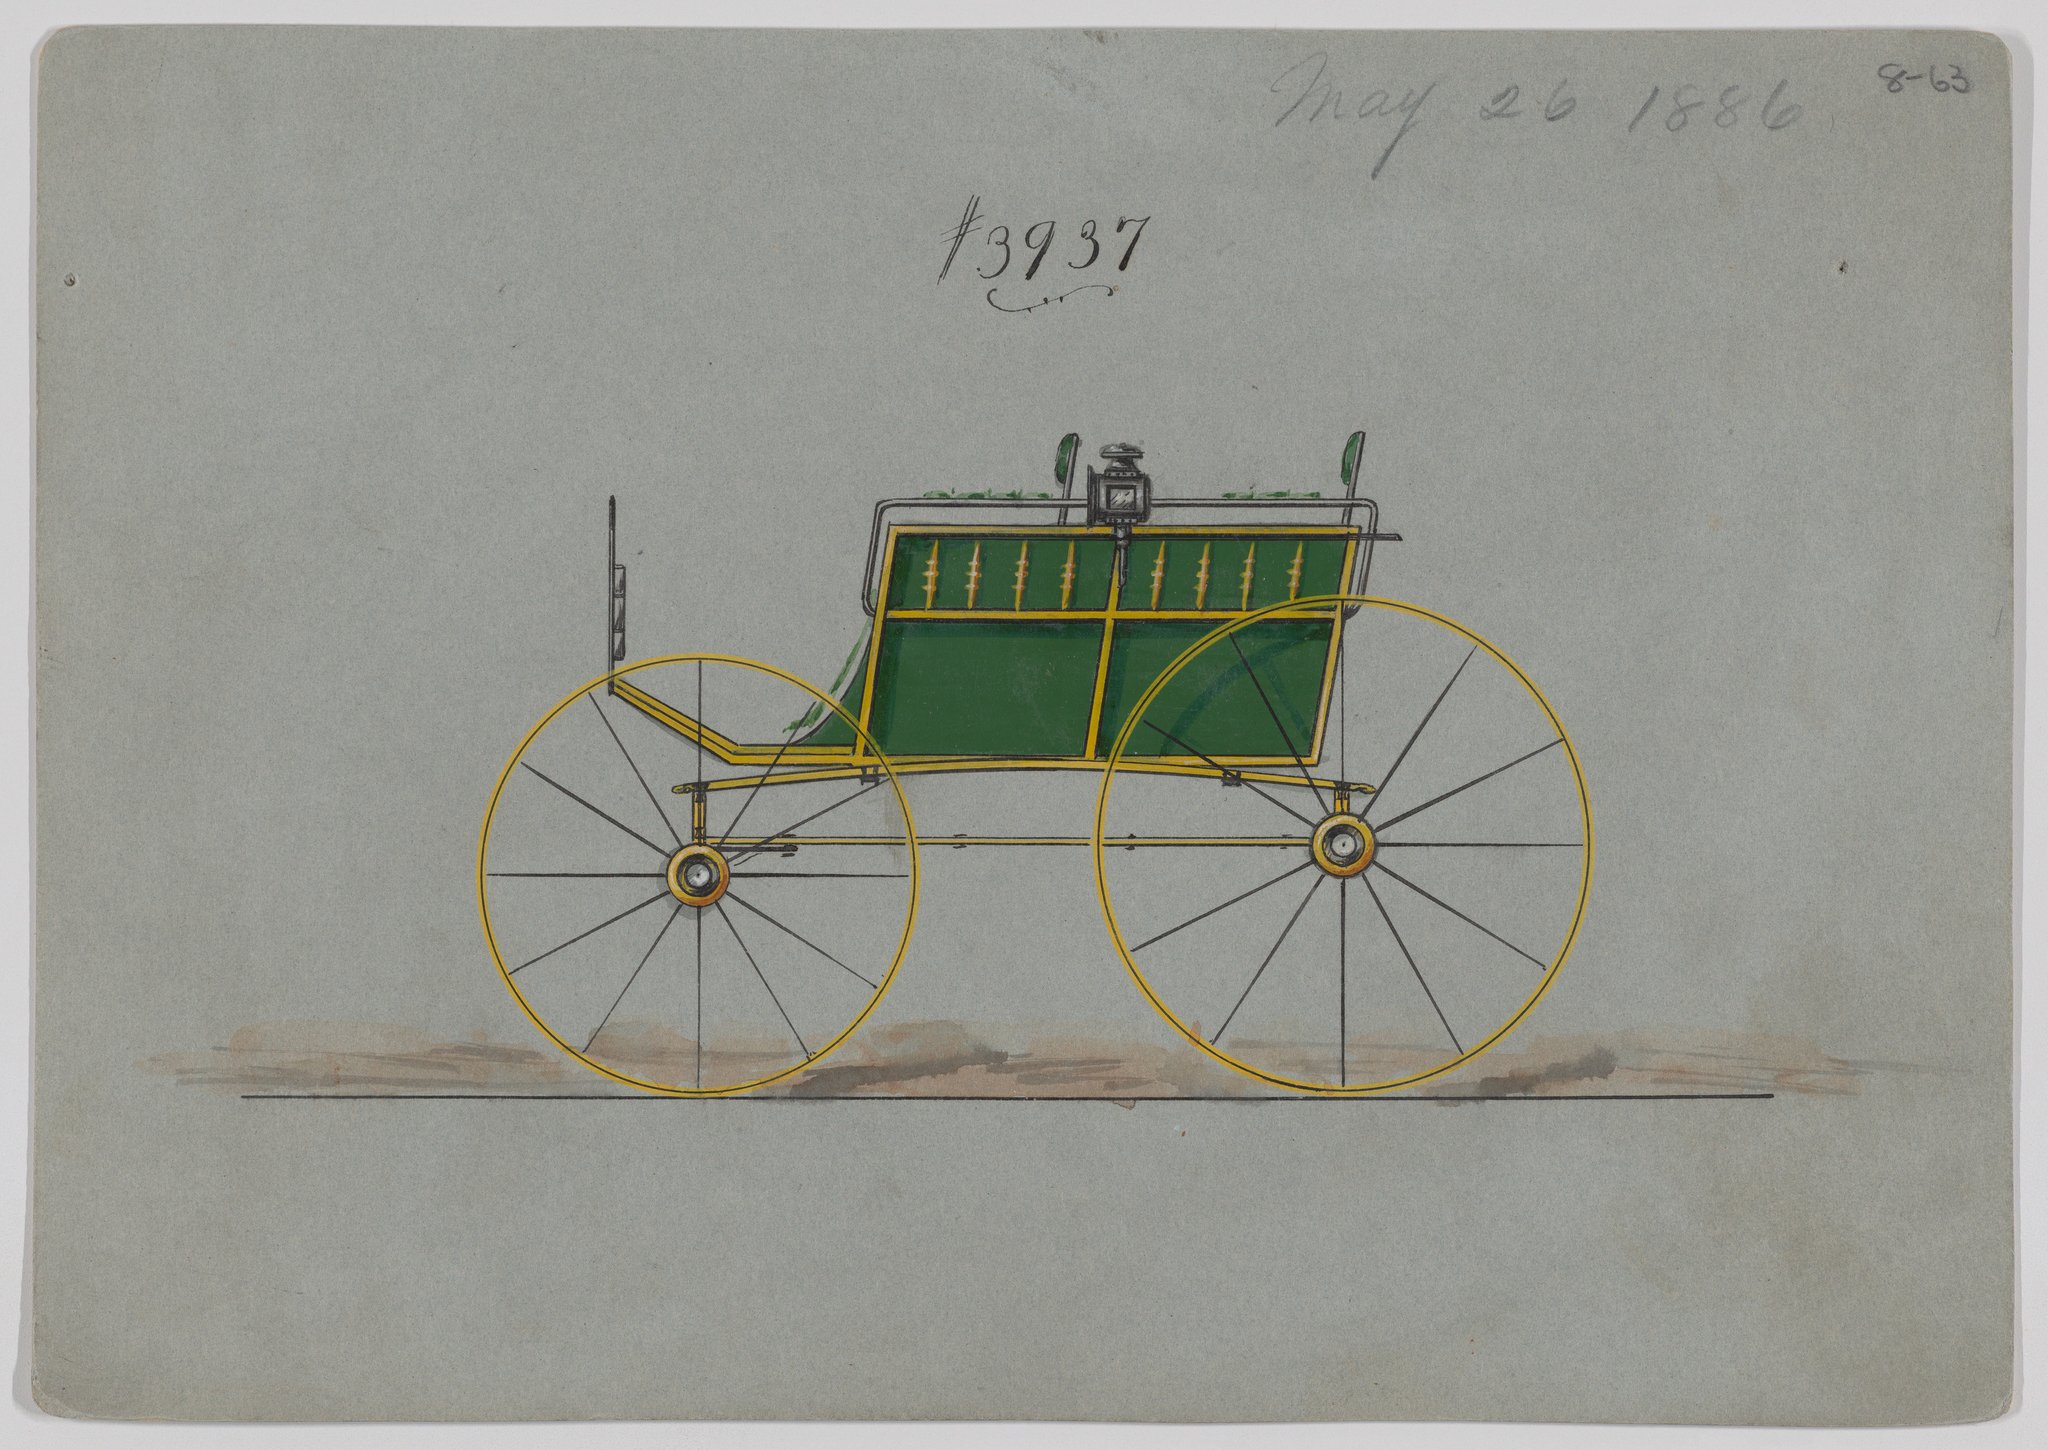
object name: drawing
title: Design for 4 seat Phaeton, no top, no. 3937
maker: brewster & co.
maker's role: manufacturer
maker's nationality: american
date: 1885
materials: gouache, gum arabic, ink, watercolor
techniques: pen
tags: carriages